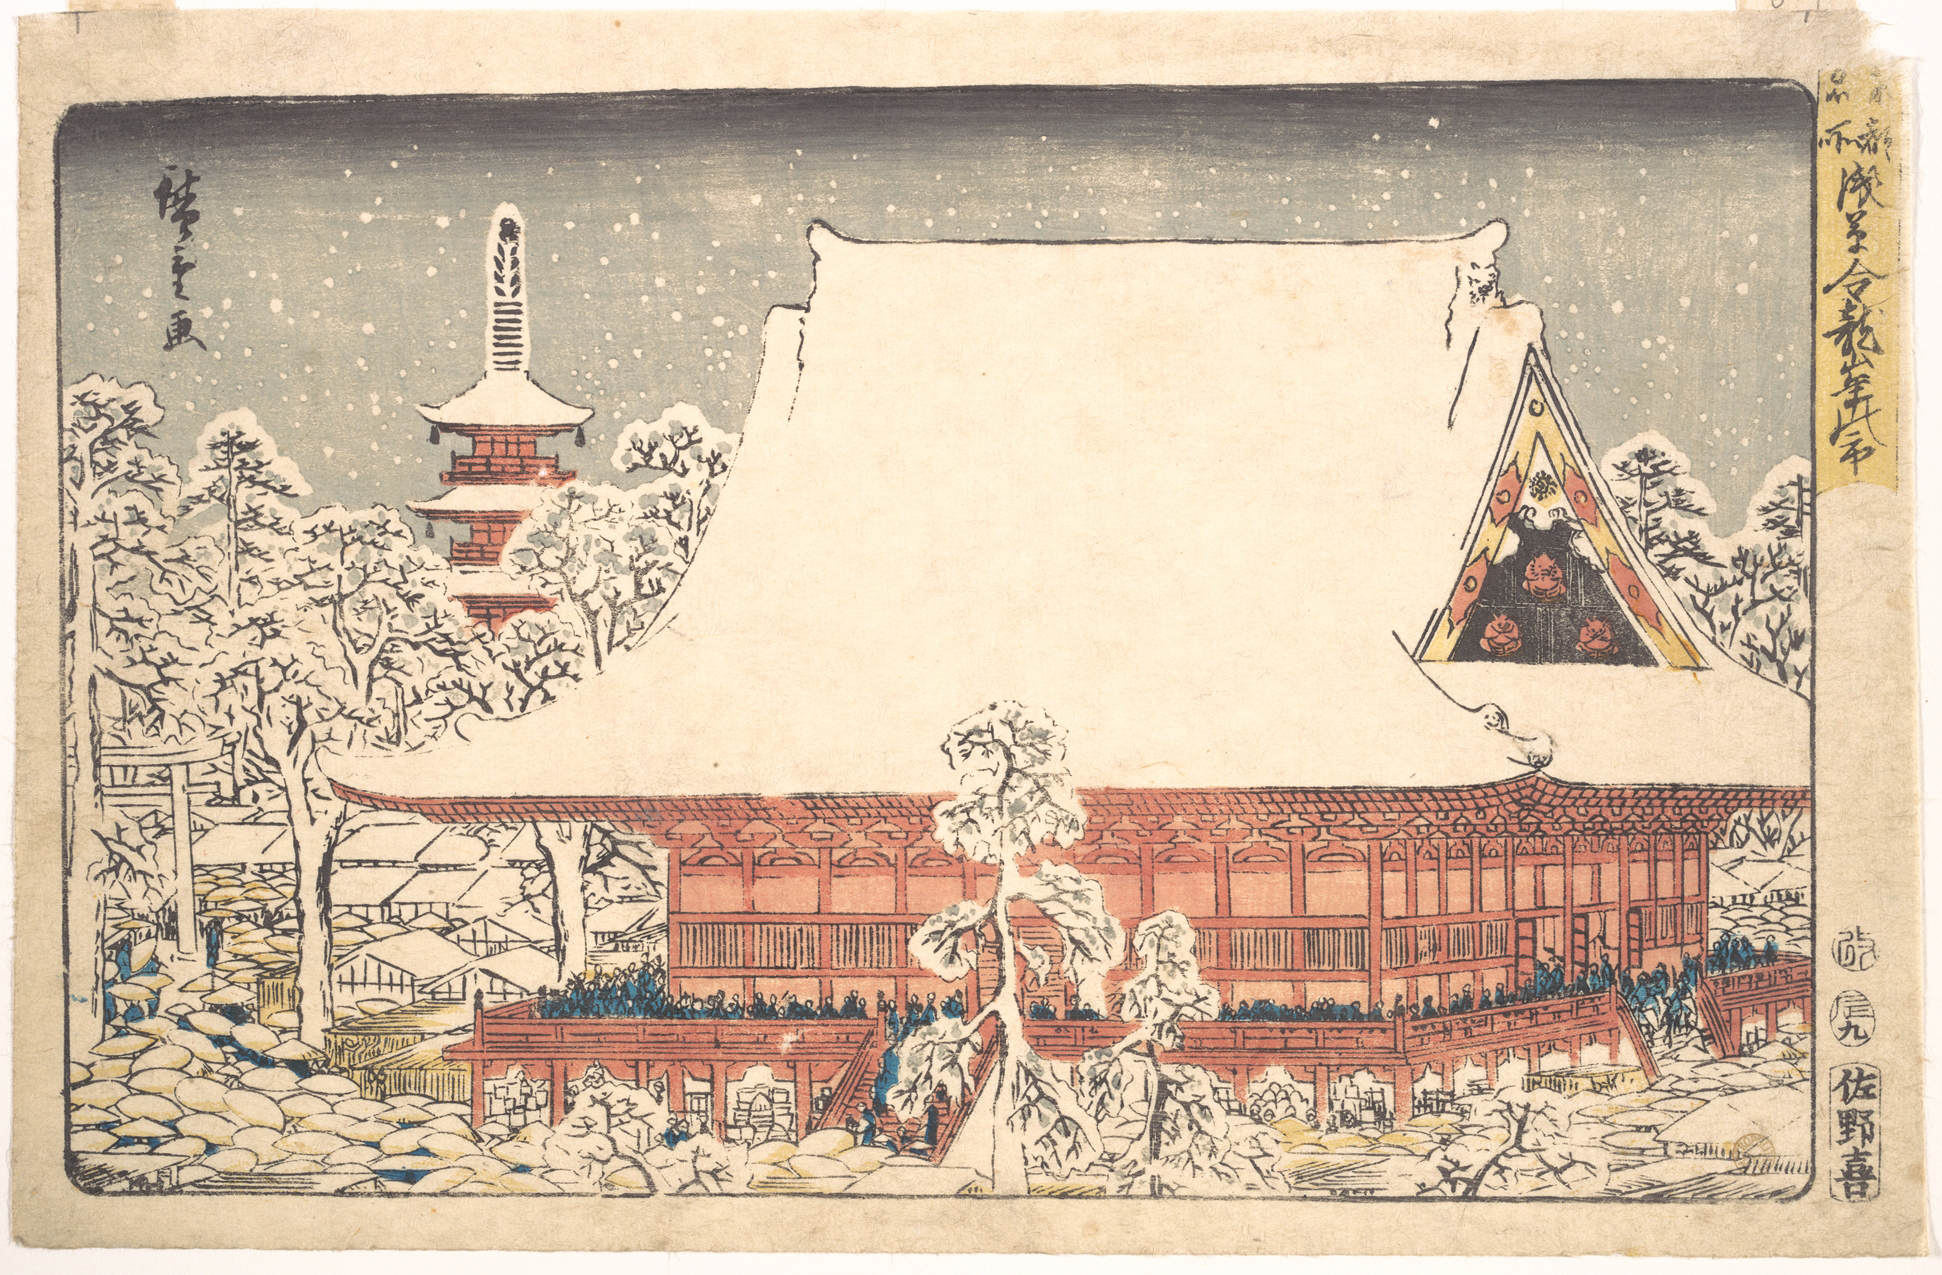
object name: print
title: Asakusa Kinryusan Toshi no Ichi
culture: japanese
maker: utagawa hiroshige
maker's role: artist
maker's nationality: japanese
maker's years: 1797-1858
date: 1838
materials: ink, paper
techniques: woodblock print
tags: temples,trees,snow